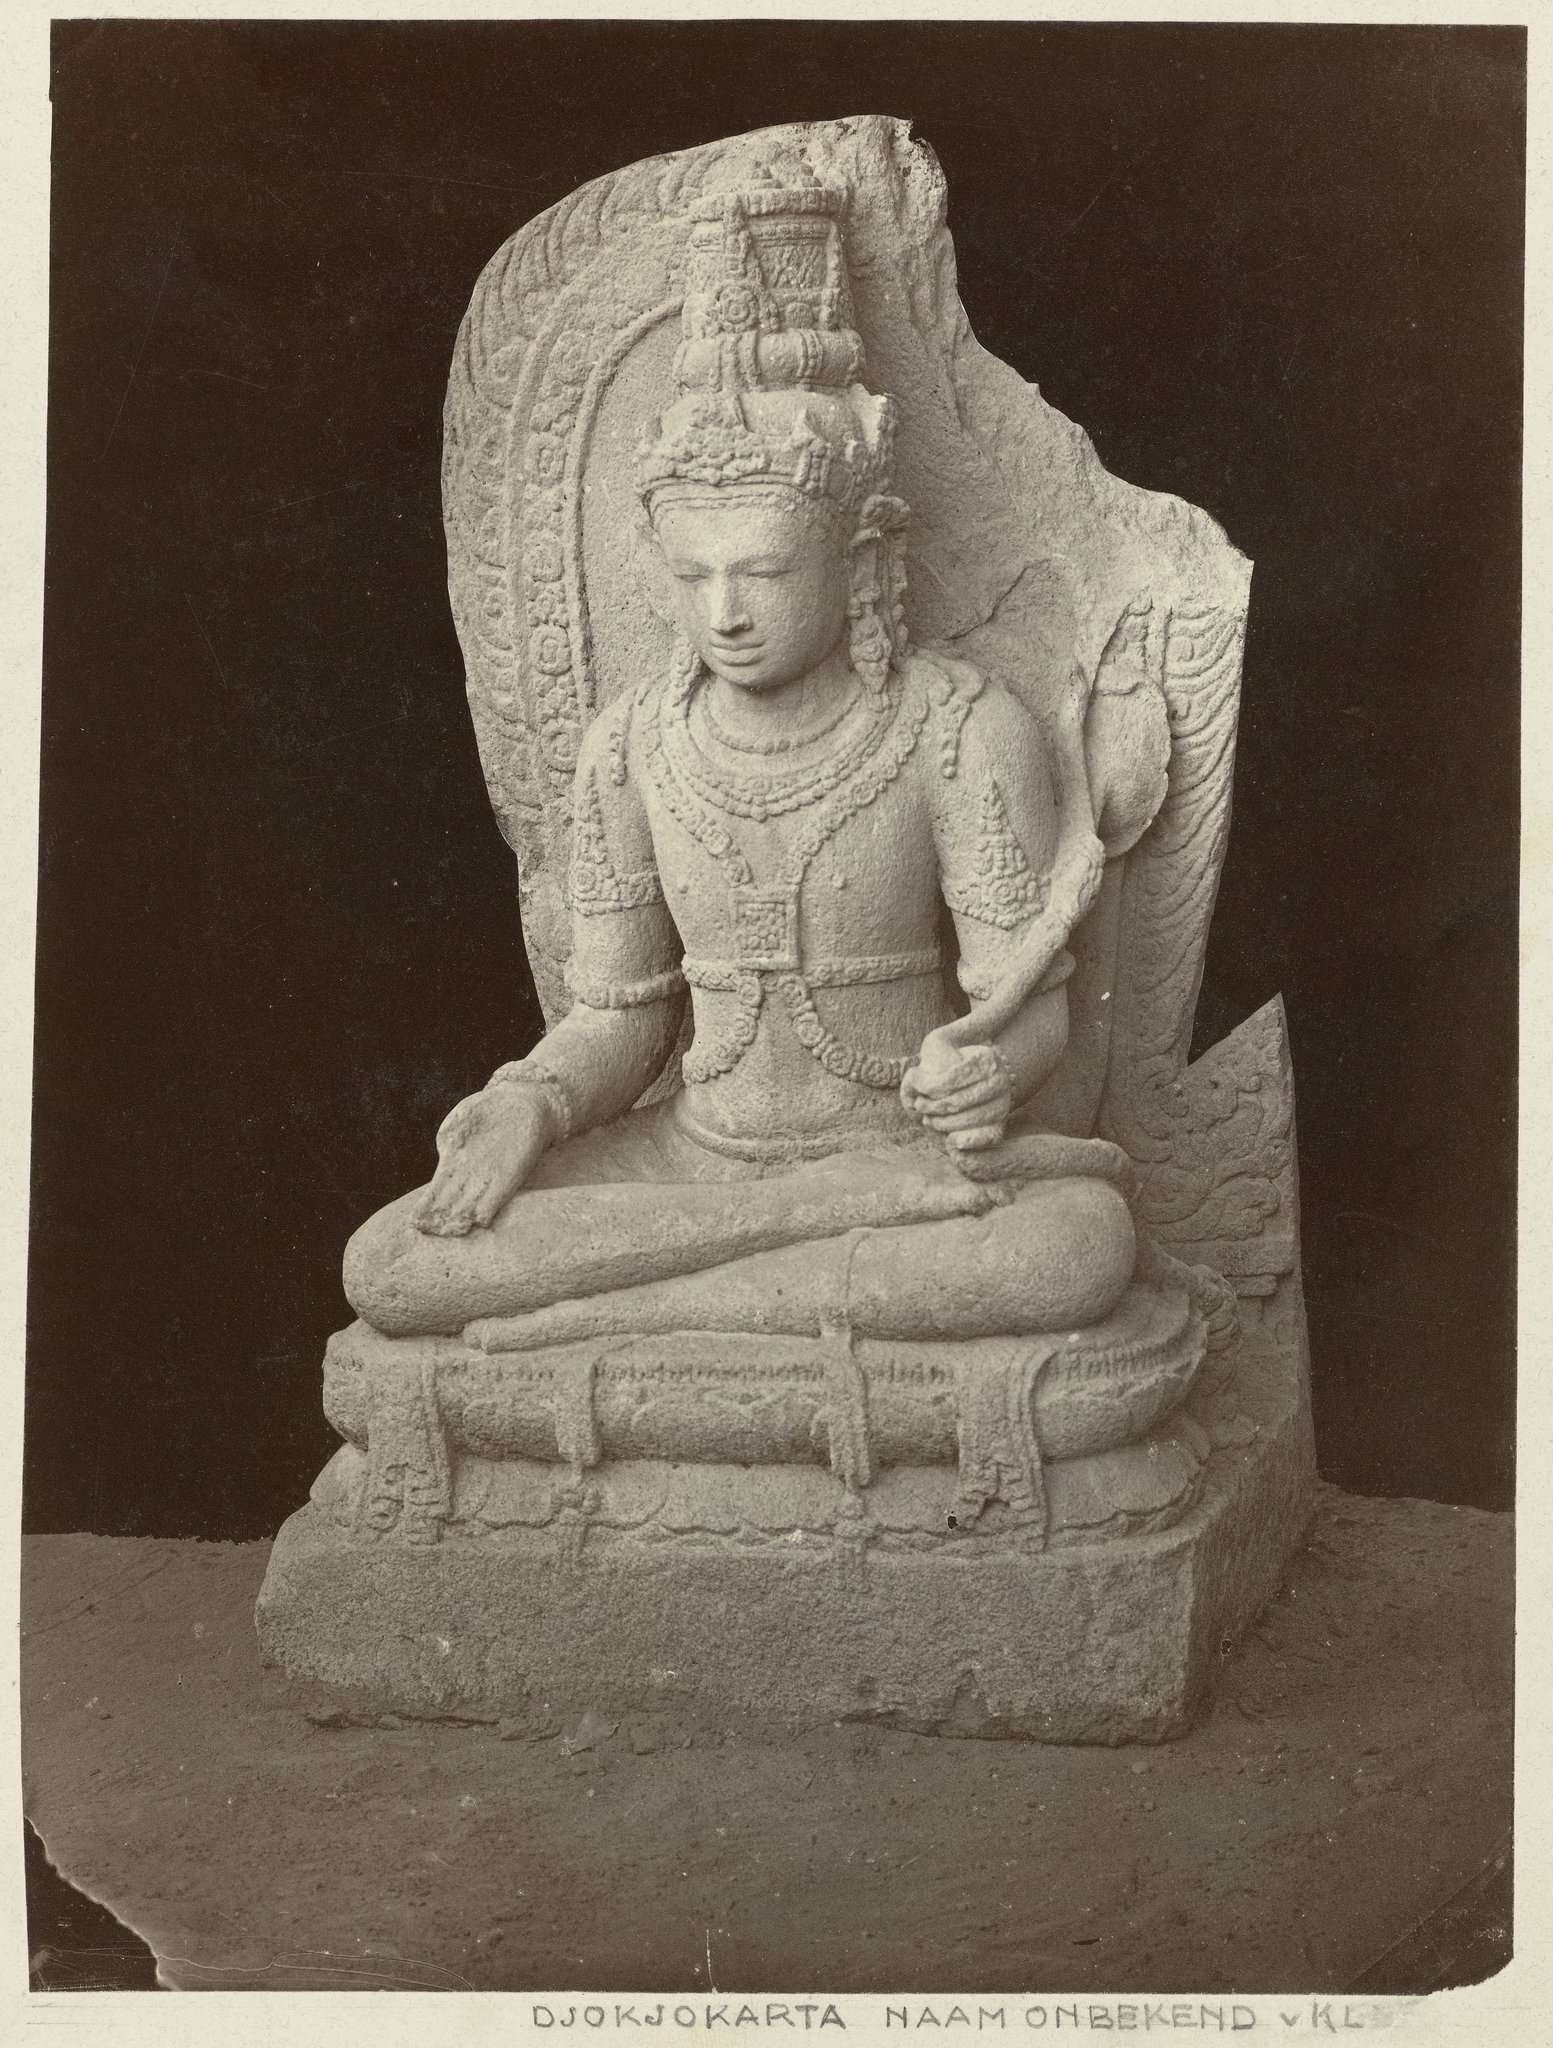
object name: photograph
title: Bodhisattva Avalokiteshvara displaying the varadanudra, probably from Candi Plaosan. Yogyakarta, Yogyakarta district, D.I, Yogyakarta province, 9th century.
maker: isidore kinsbergen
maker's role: fotograaf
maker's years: 1821-1905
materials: cardboard, paper, photographic support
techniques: albumen print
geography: java